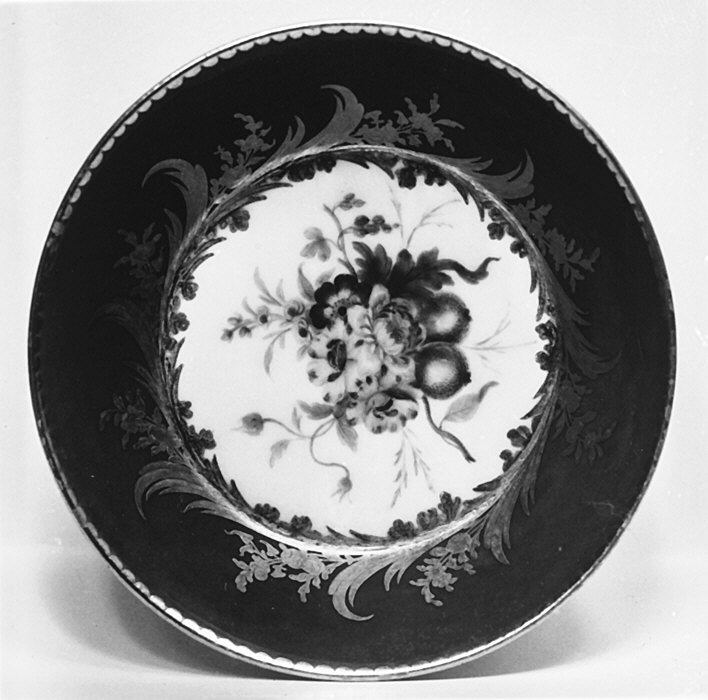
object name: saucer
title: Saucer (one of nine) (part of a service)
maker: sèvres manufactory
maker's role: manufactory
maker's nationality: french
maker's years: 1740-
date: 1786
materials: soft paste porcelain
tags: flowers